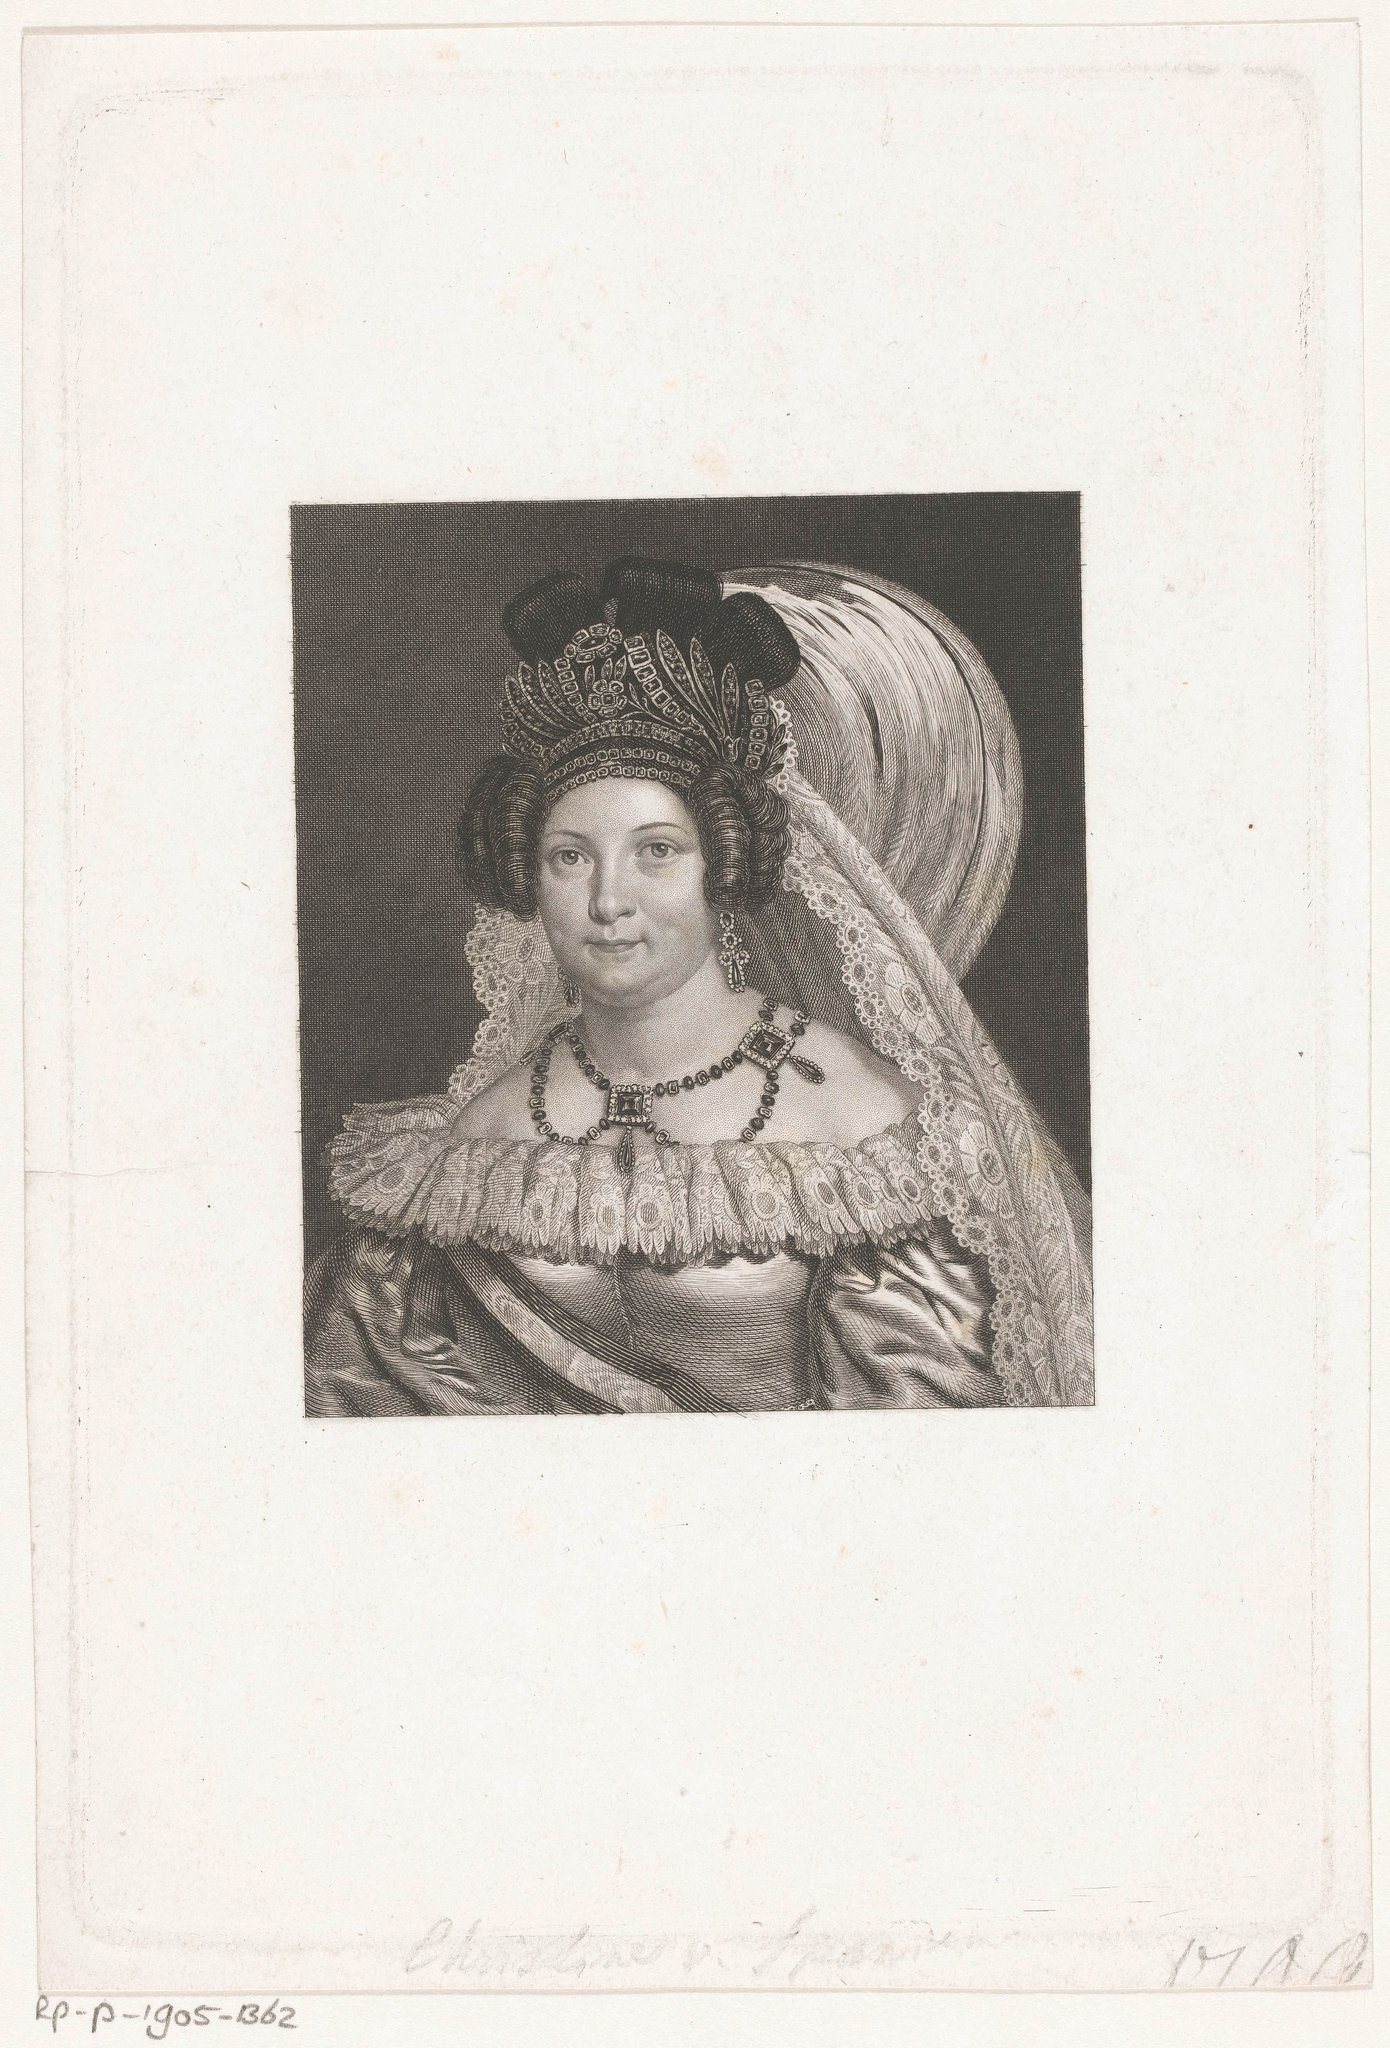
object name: print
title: Portret van Maria Christina, koningin van Spanje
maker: friedrich fleischmann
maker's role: print maker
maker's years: 1791-1834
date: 1816-1834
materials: paper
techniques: engraving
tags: historical persons - bb - woman, ruler, sovereign - bb - female ruler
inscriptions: collector's mark: Lugt 2228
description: Latere staat gebruikt in portretserie: 'Zeitgenossen', uitgegeven tussen 1829 en circa 1840.